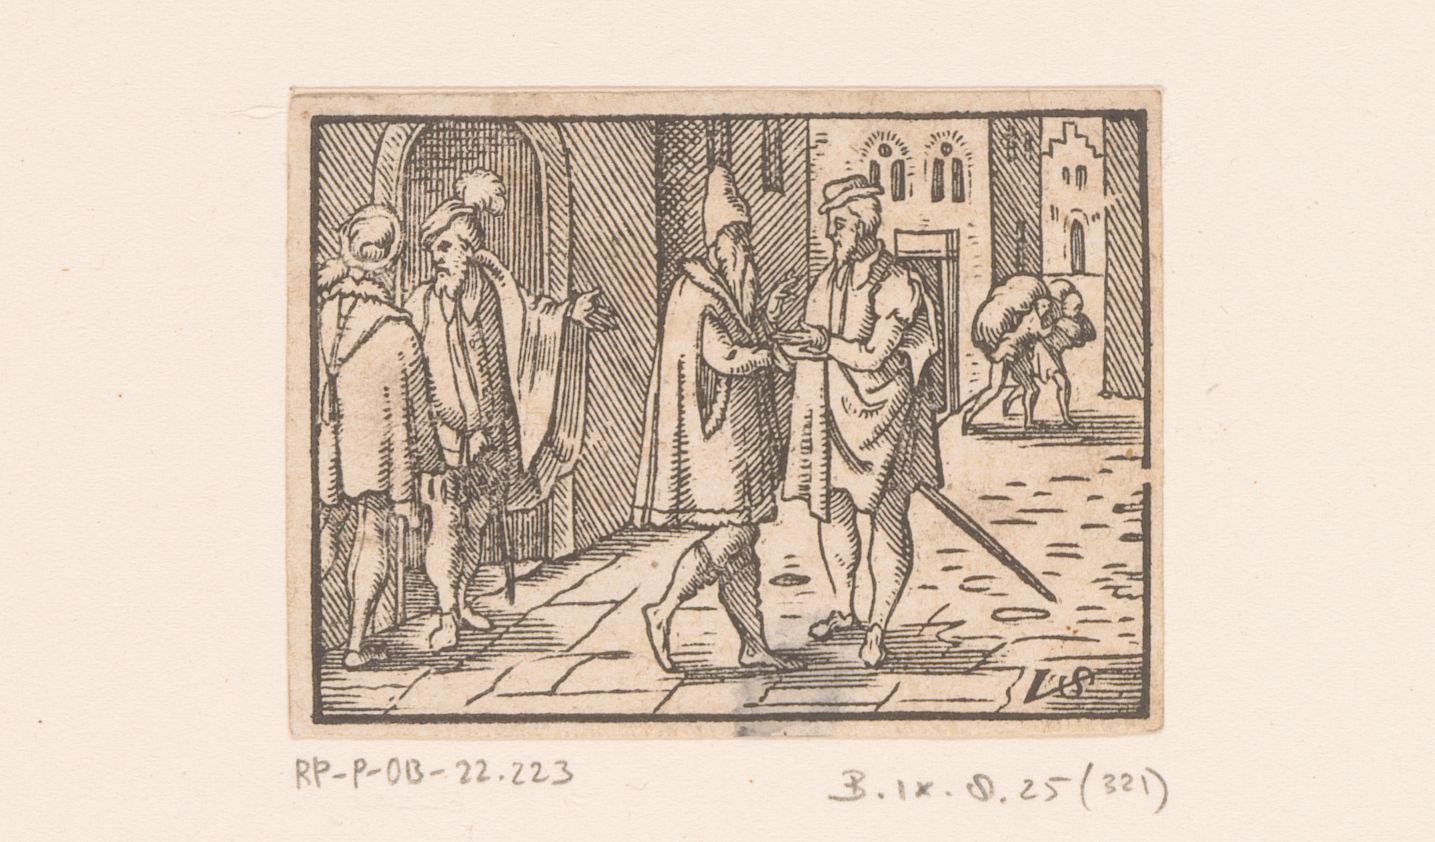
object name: print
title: Fabel van de opschepper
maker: virgilius solis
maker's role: draughtsman, print maker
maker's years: 1514-1562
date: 1566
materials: paper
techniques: woodcut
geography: nuremberg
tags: city-view in general; 'veduta', conversation, dialogue; conversation piece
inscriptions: number: ‘184’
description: Illustratie bij de Fabels van Aesopus, onder meer gebruikt voor de publicatie: Posthius, Johann. Aesopi Phrygis Fabulae. Frankfurt am Main: Sigmund Feyerabend, Georg Rab en erven Weigand Han, 1566.